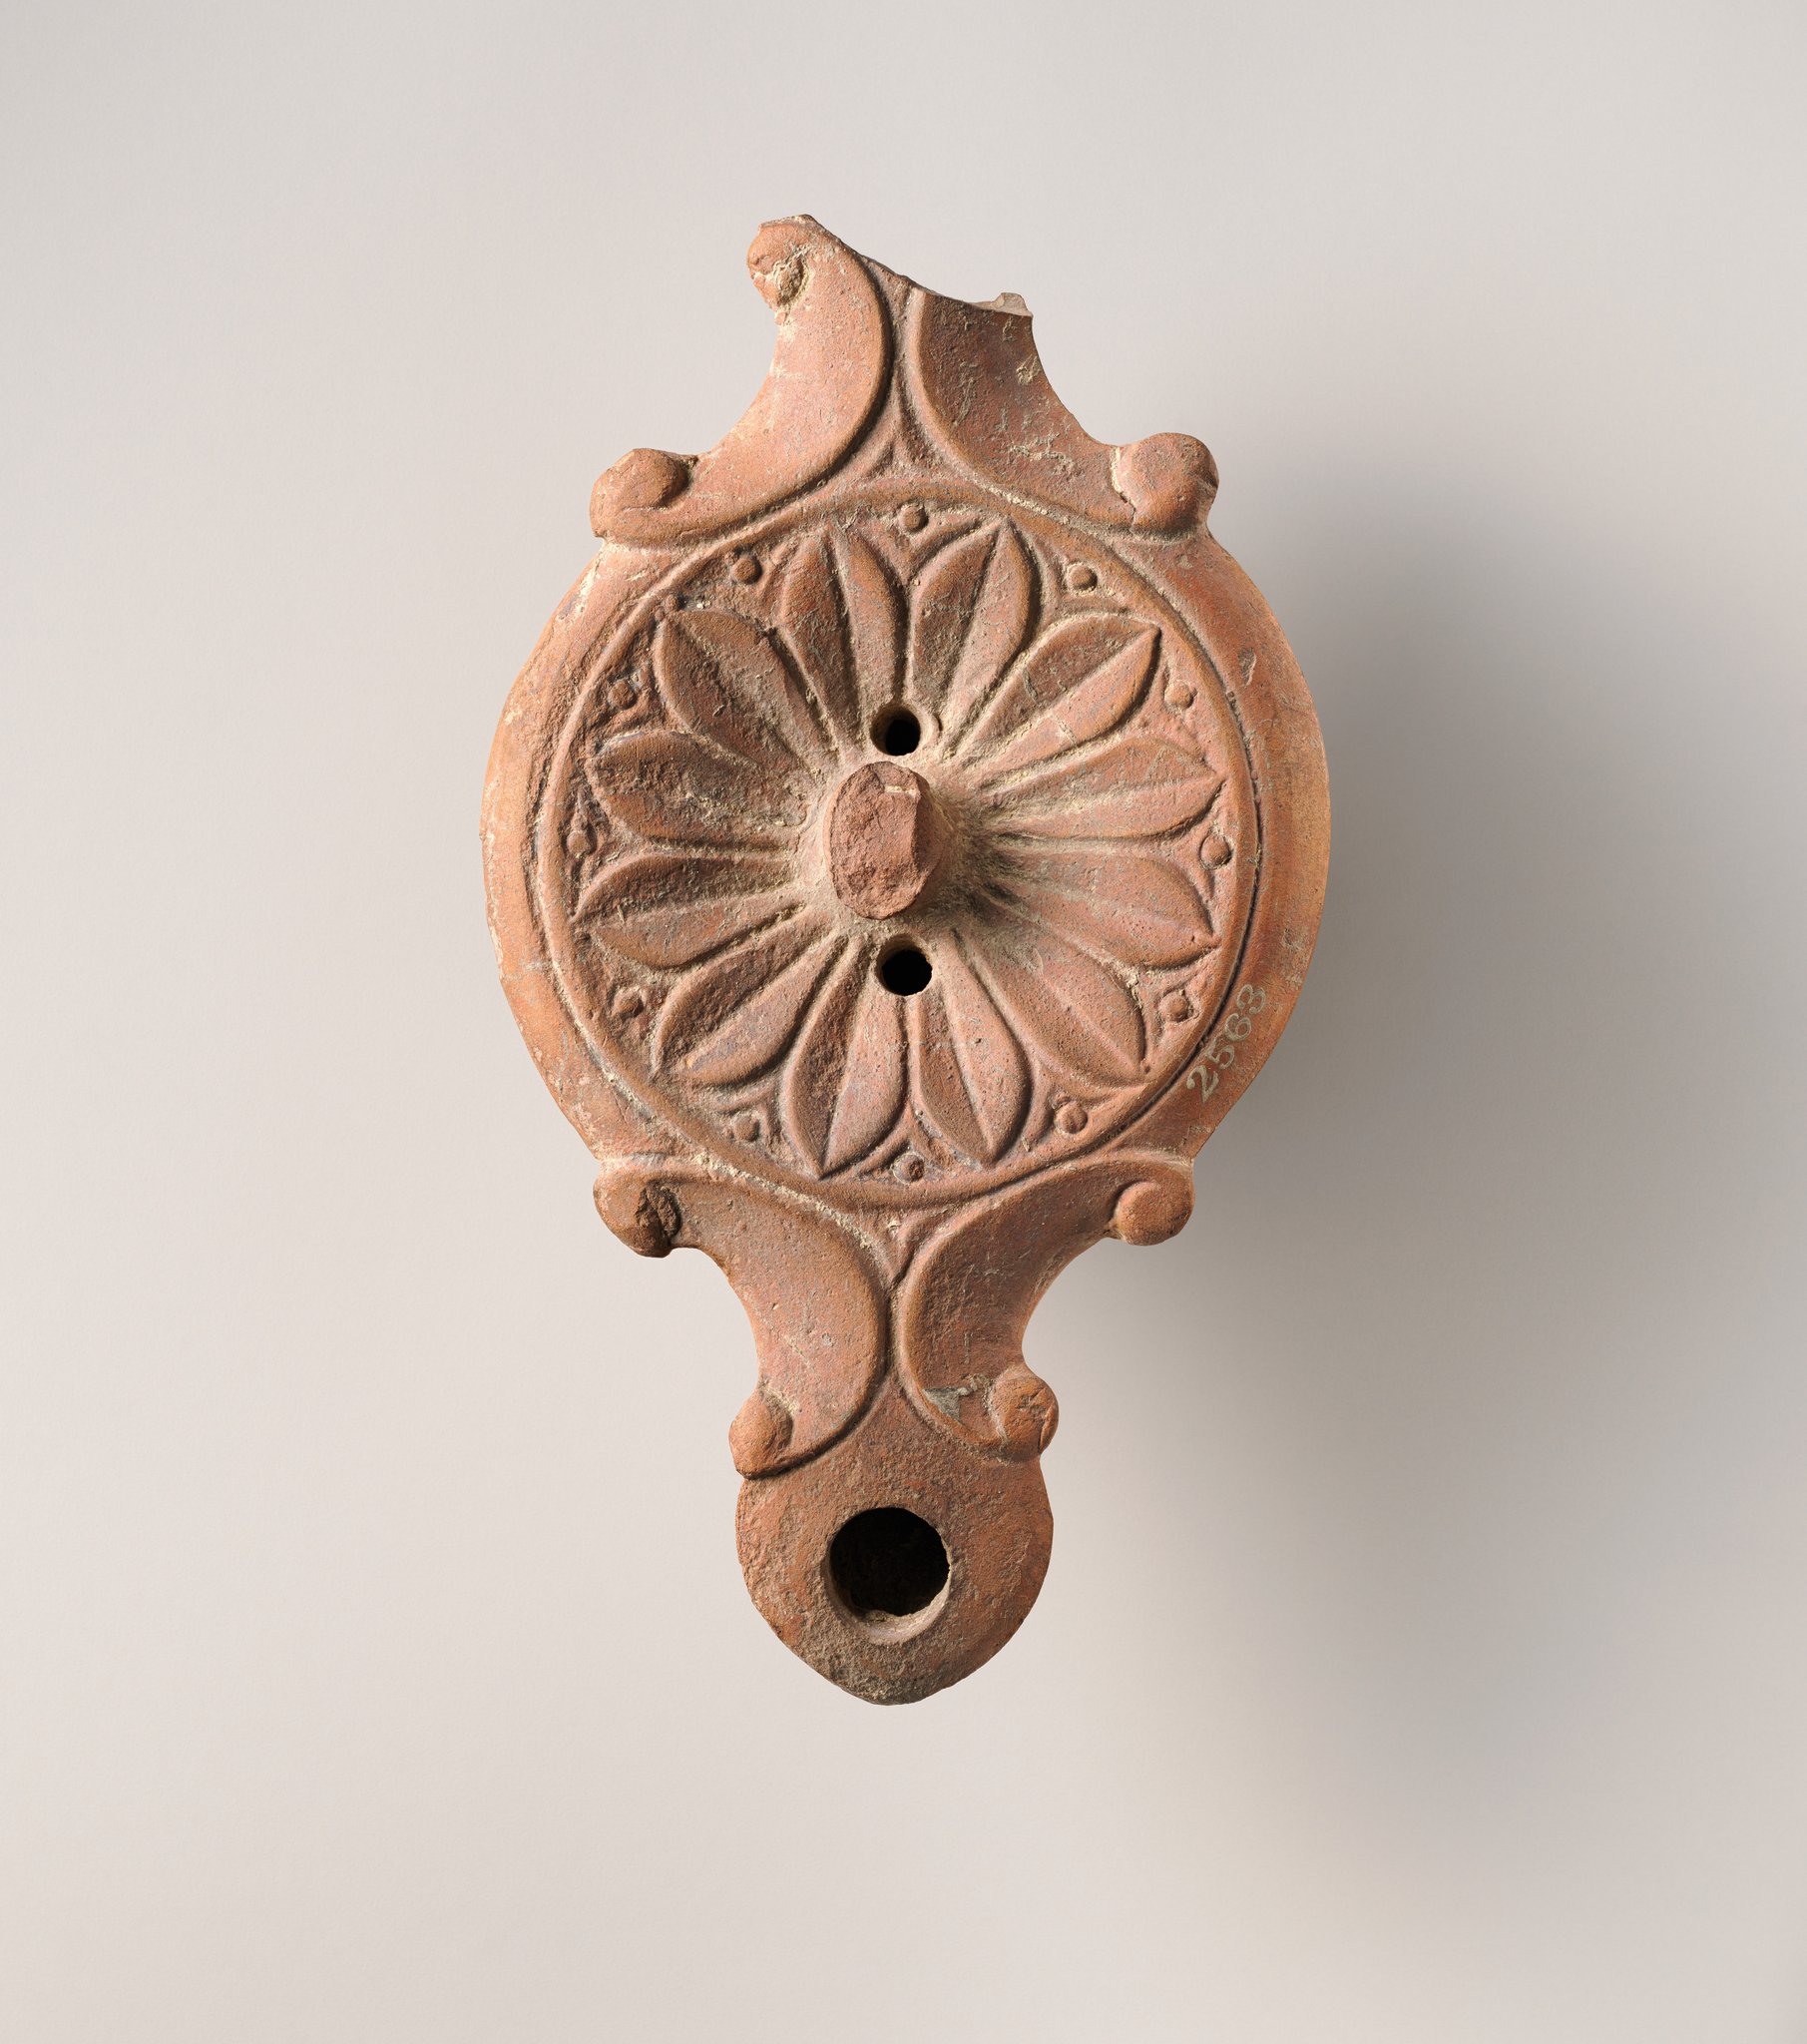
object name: lamp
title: Terracotta oil lamp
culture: roman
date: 1-100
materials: terracotta